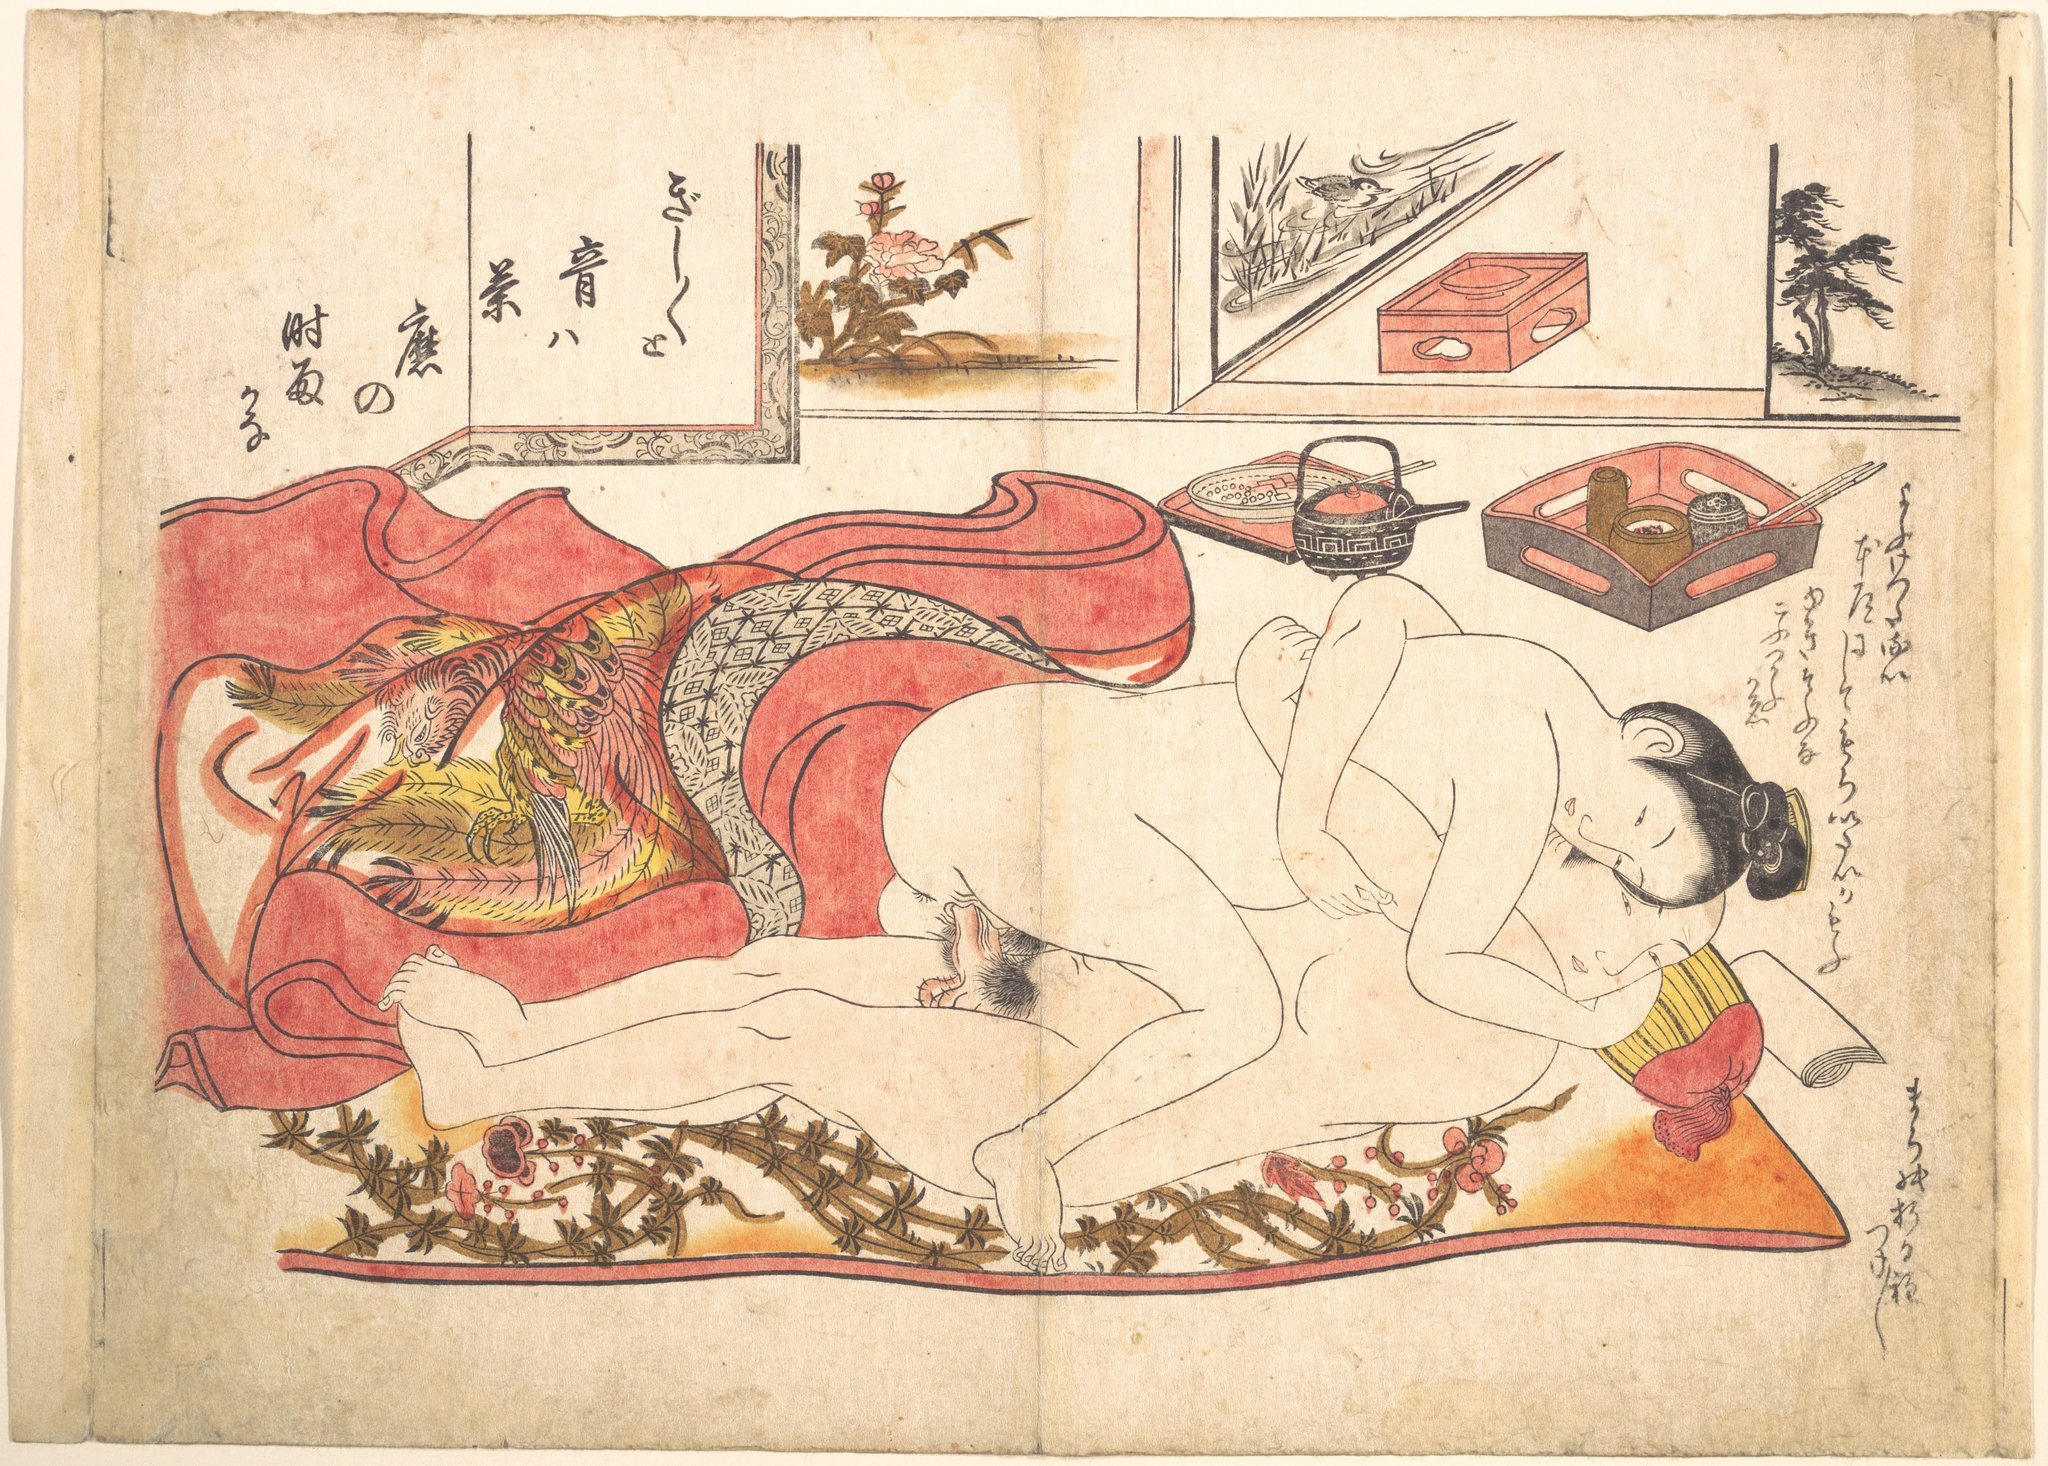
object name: print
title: Bedroom Scene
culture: japanese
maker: okumura masanobu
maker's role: artist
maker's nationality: japanese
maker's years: 1686-1764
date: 1739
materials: ink, paper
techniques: hand coloring, woodblock print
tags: male nudes,female nudes